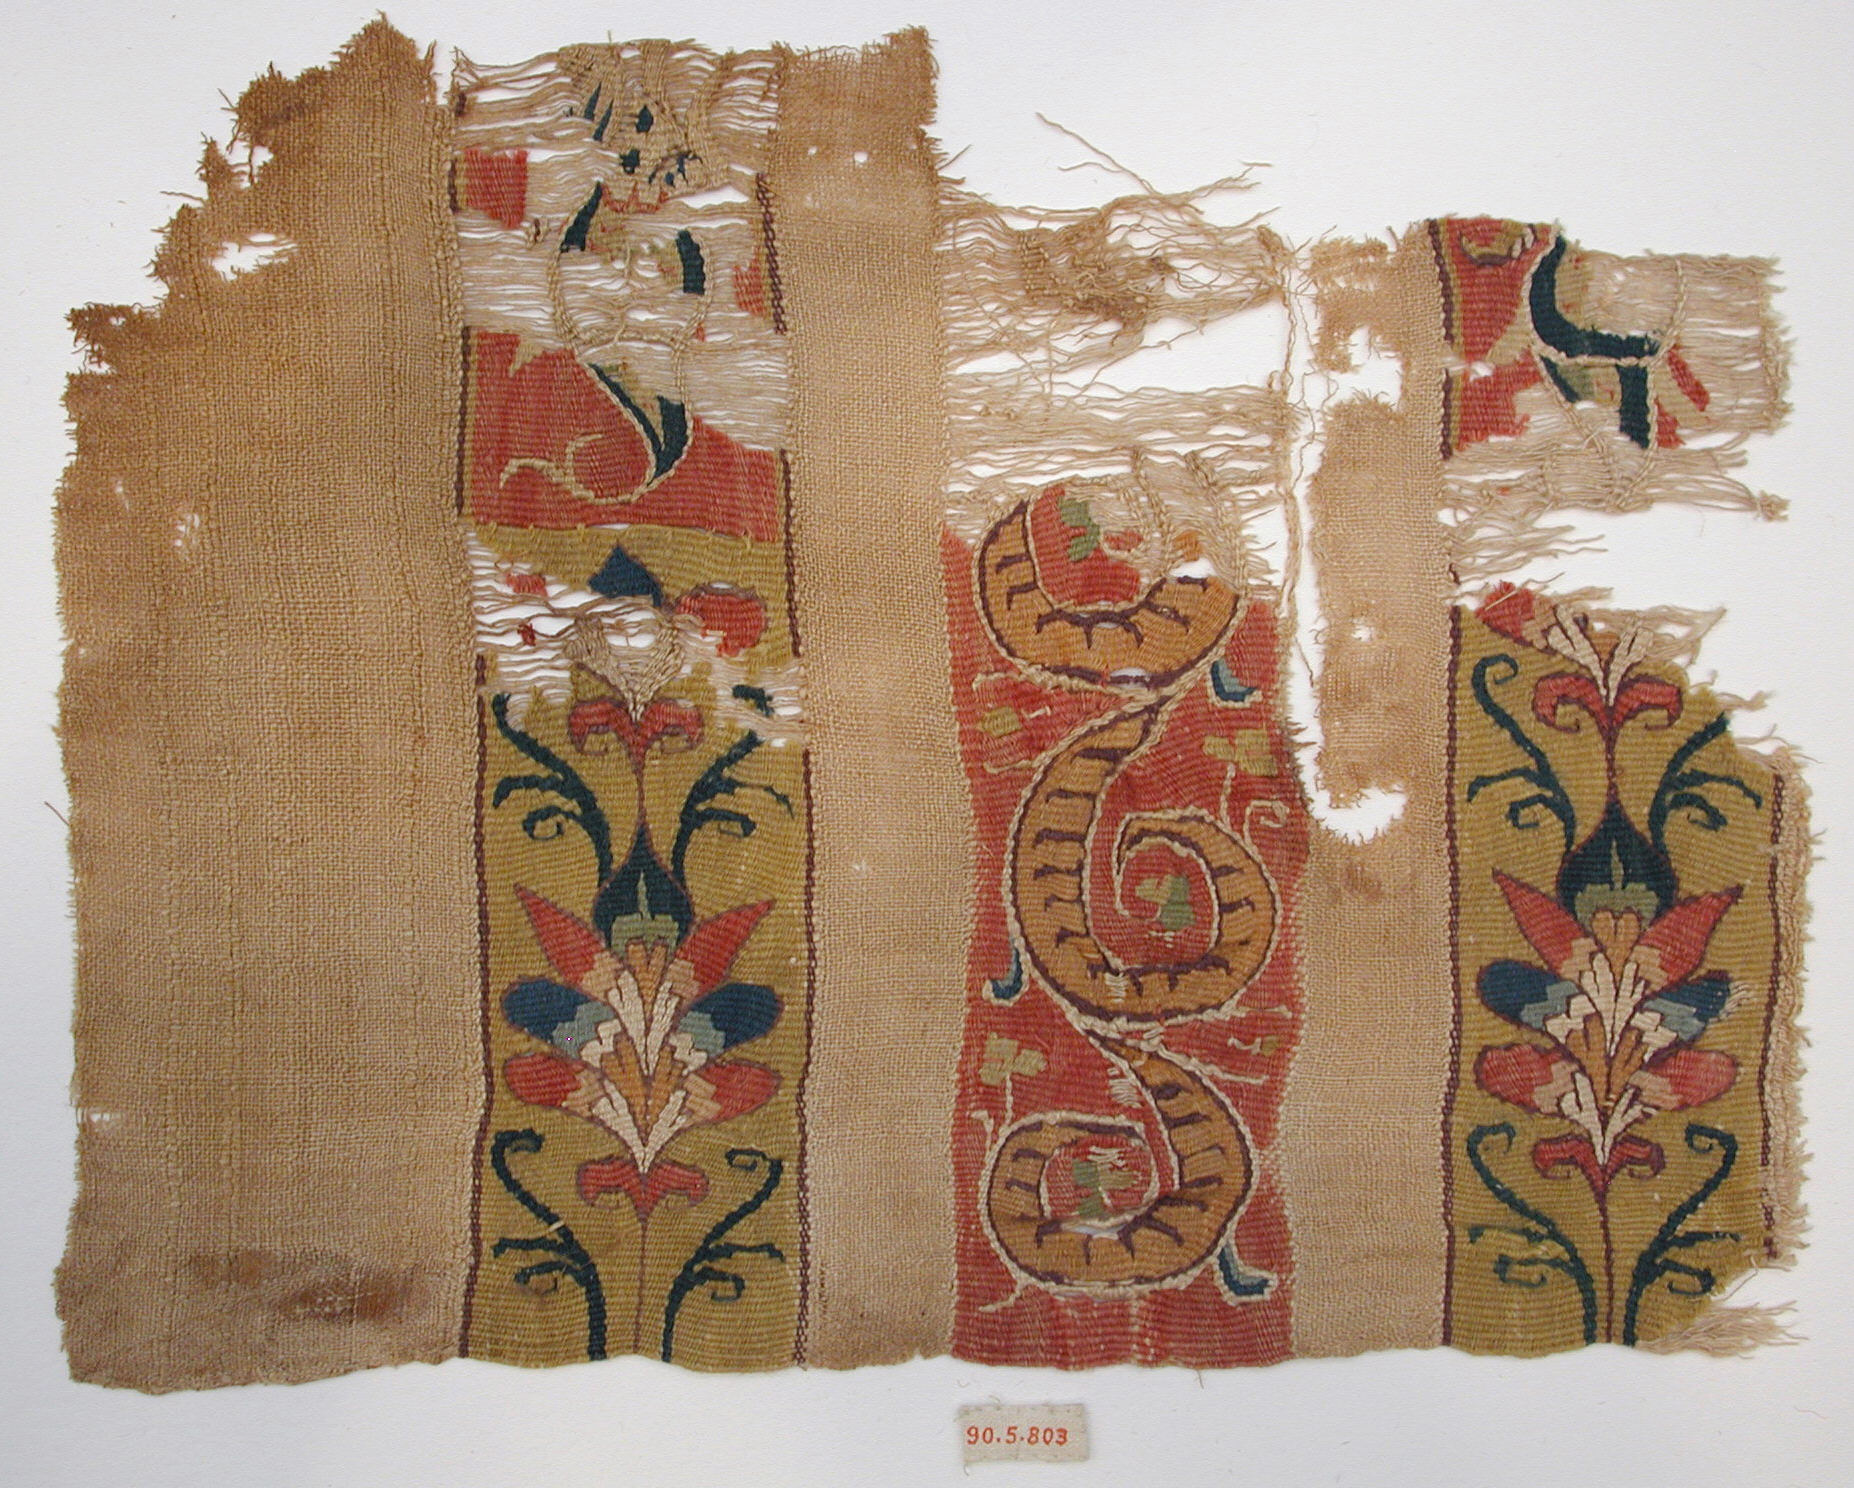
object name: textile fragment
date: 401-600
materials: linen, wool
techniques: weave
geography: egypt